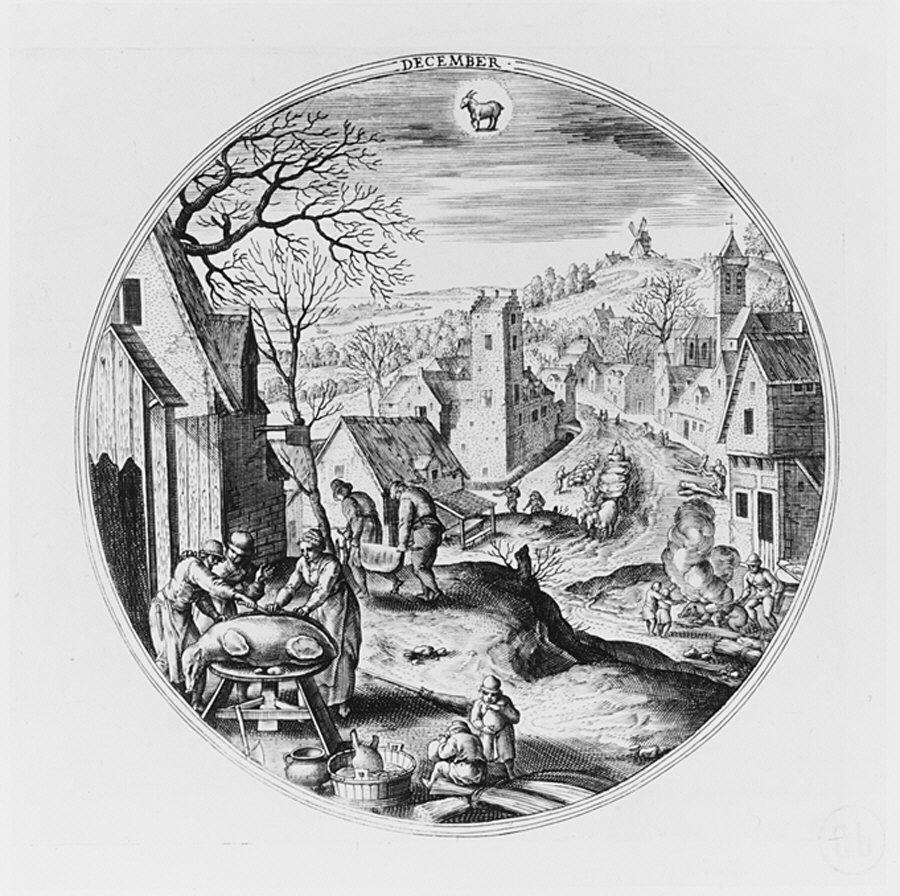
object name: print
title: December, from the series The Months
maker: adriaen collaert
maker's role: artist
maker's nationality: netherlandish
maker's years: 1560-1618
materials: paper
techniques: engraving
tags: human figures,buildings,trees,working